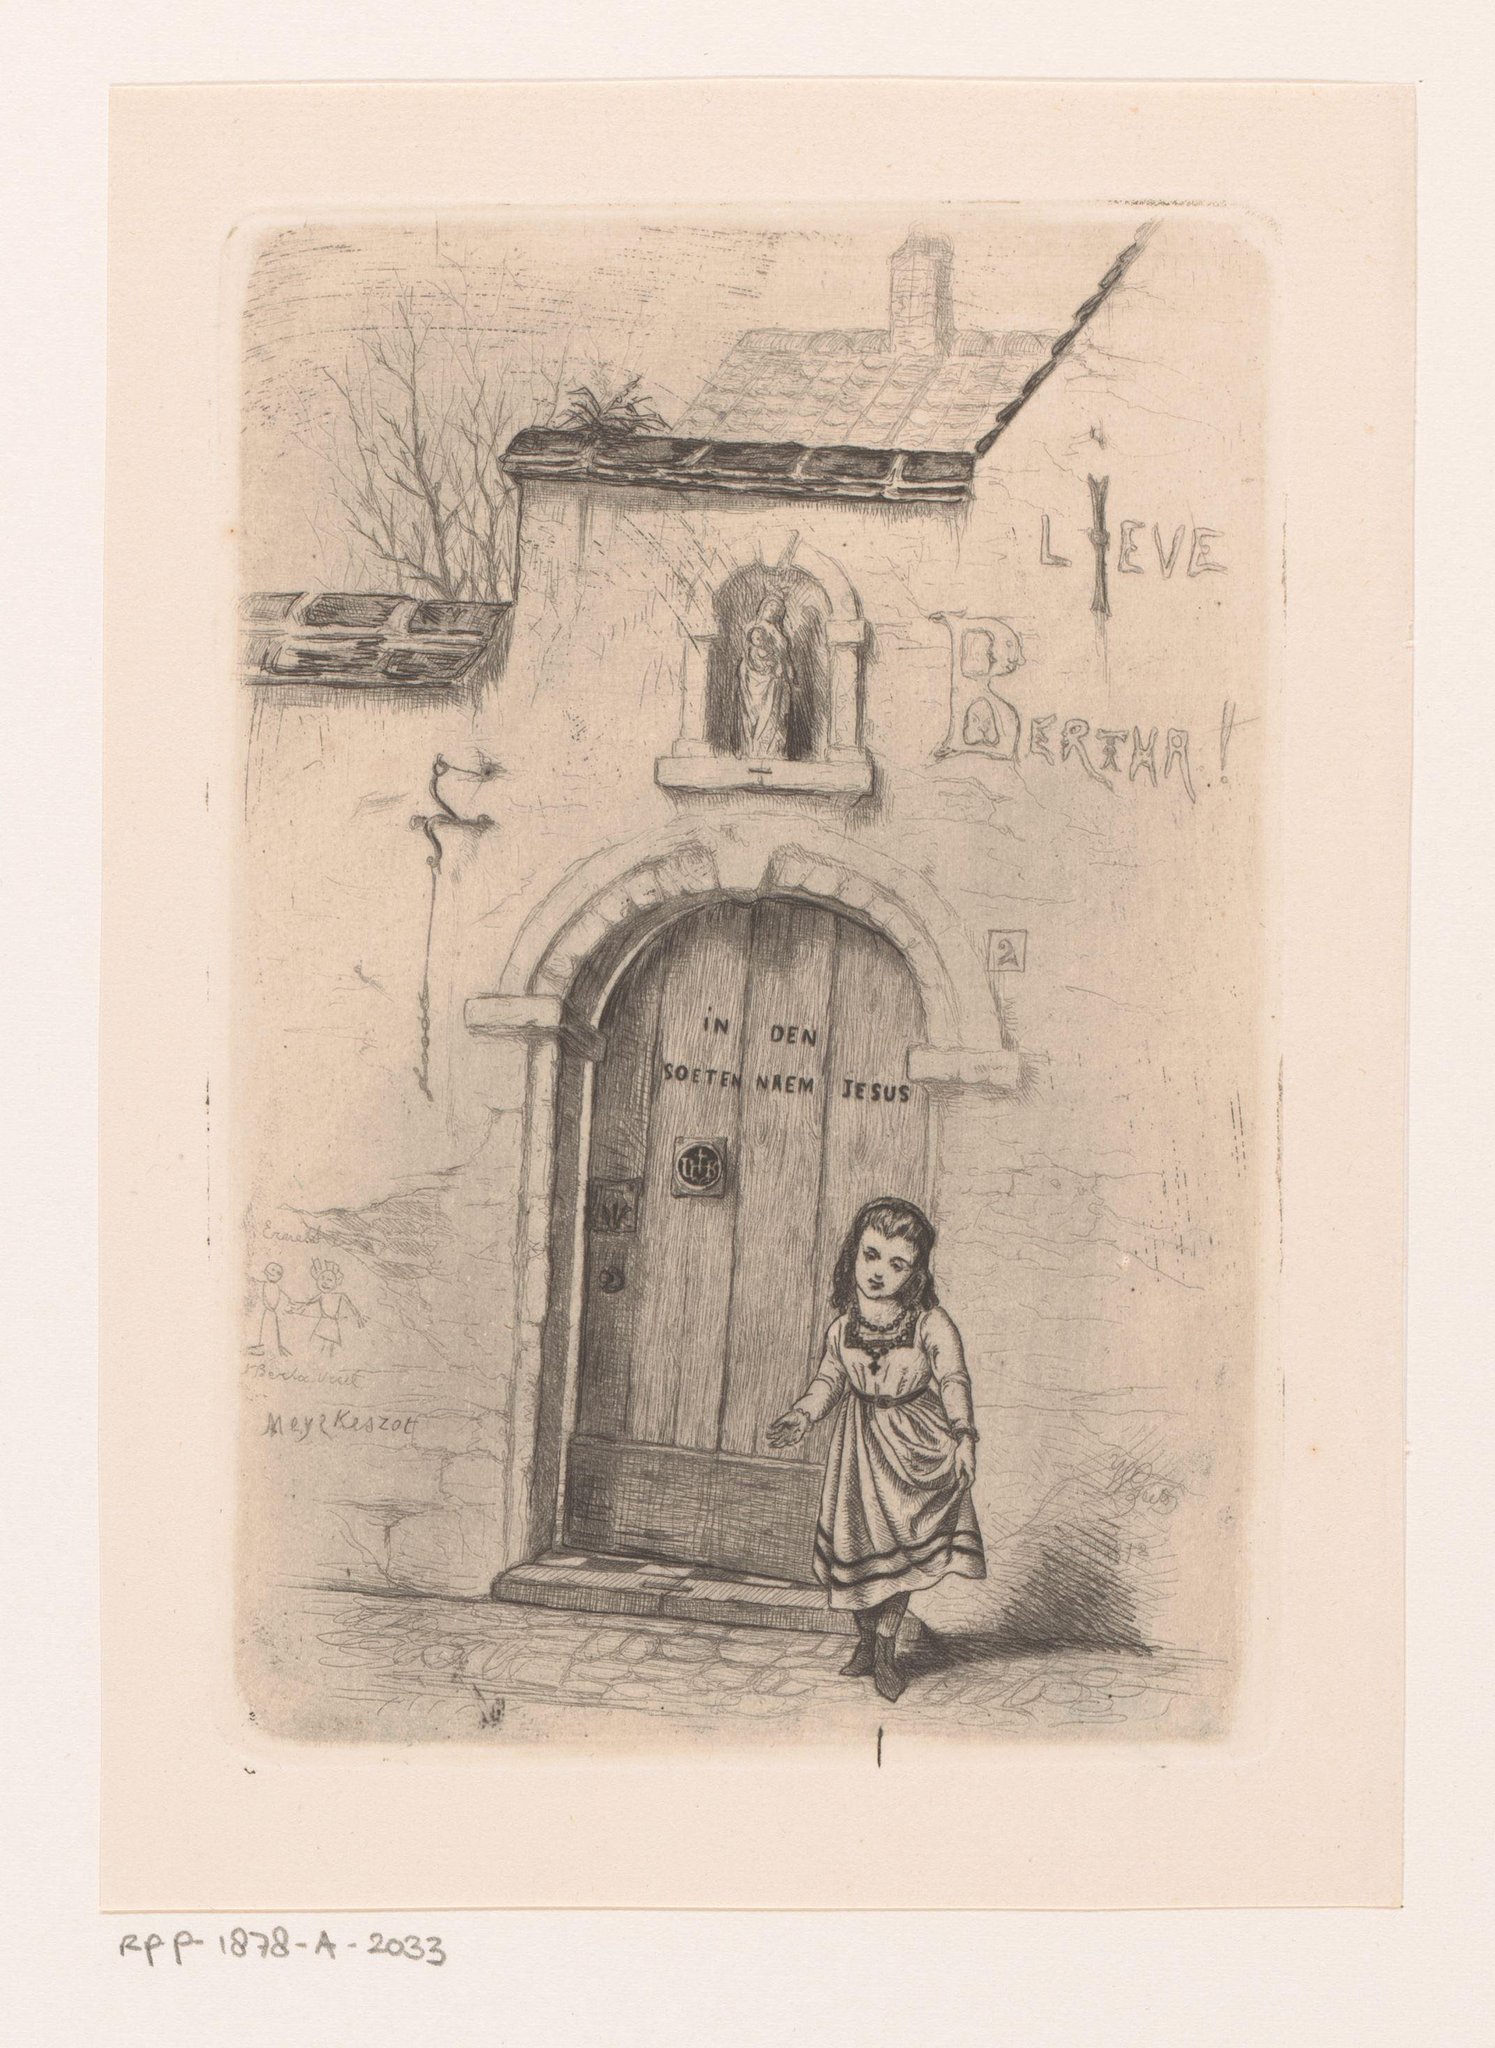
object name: book illustration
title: Lieve Bertha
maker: willem geets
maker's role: print maker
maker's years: 1838-1919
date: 1874-1875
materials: paper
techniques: etching, intaglio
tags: abbey, monastery, convent ~ roman catholic church, girl (child between toddler and youth), closed door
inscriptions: collector's mark: Lugt 2228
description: Op de poort waarvoor het meisje staat, staat: "in den soeten naem Jesus". Links op de muur is een tekening van twee figuren hand in hand aangebracht met de tekst: "Ernest t Bertha vreit Meyskeszot".